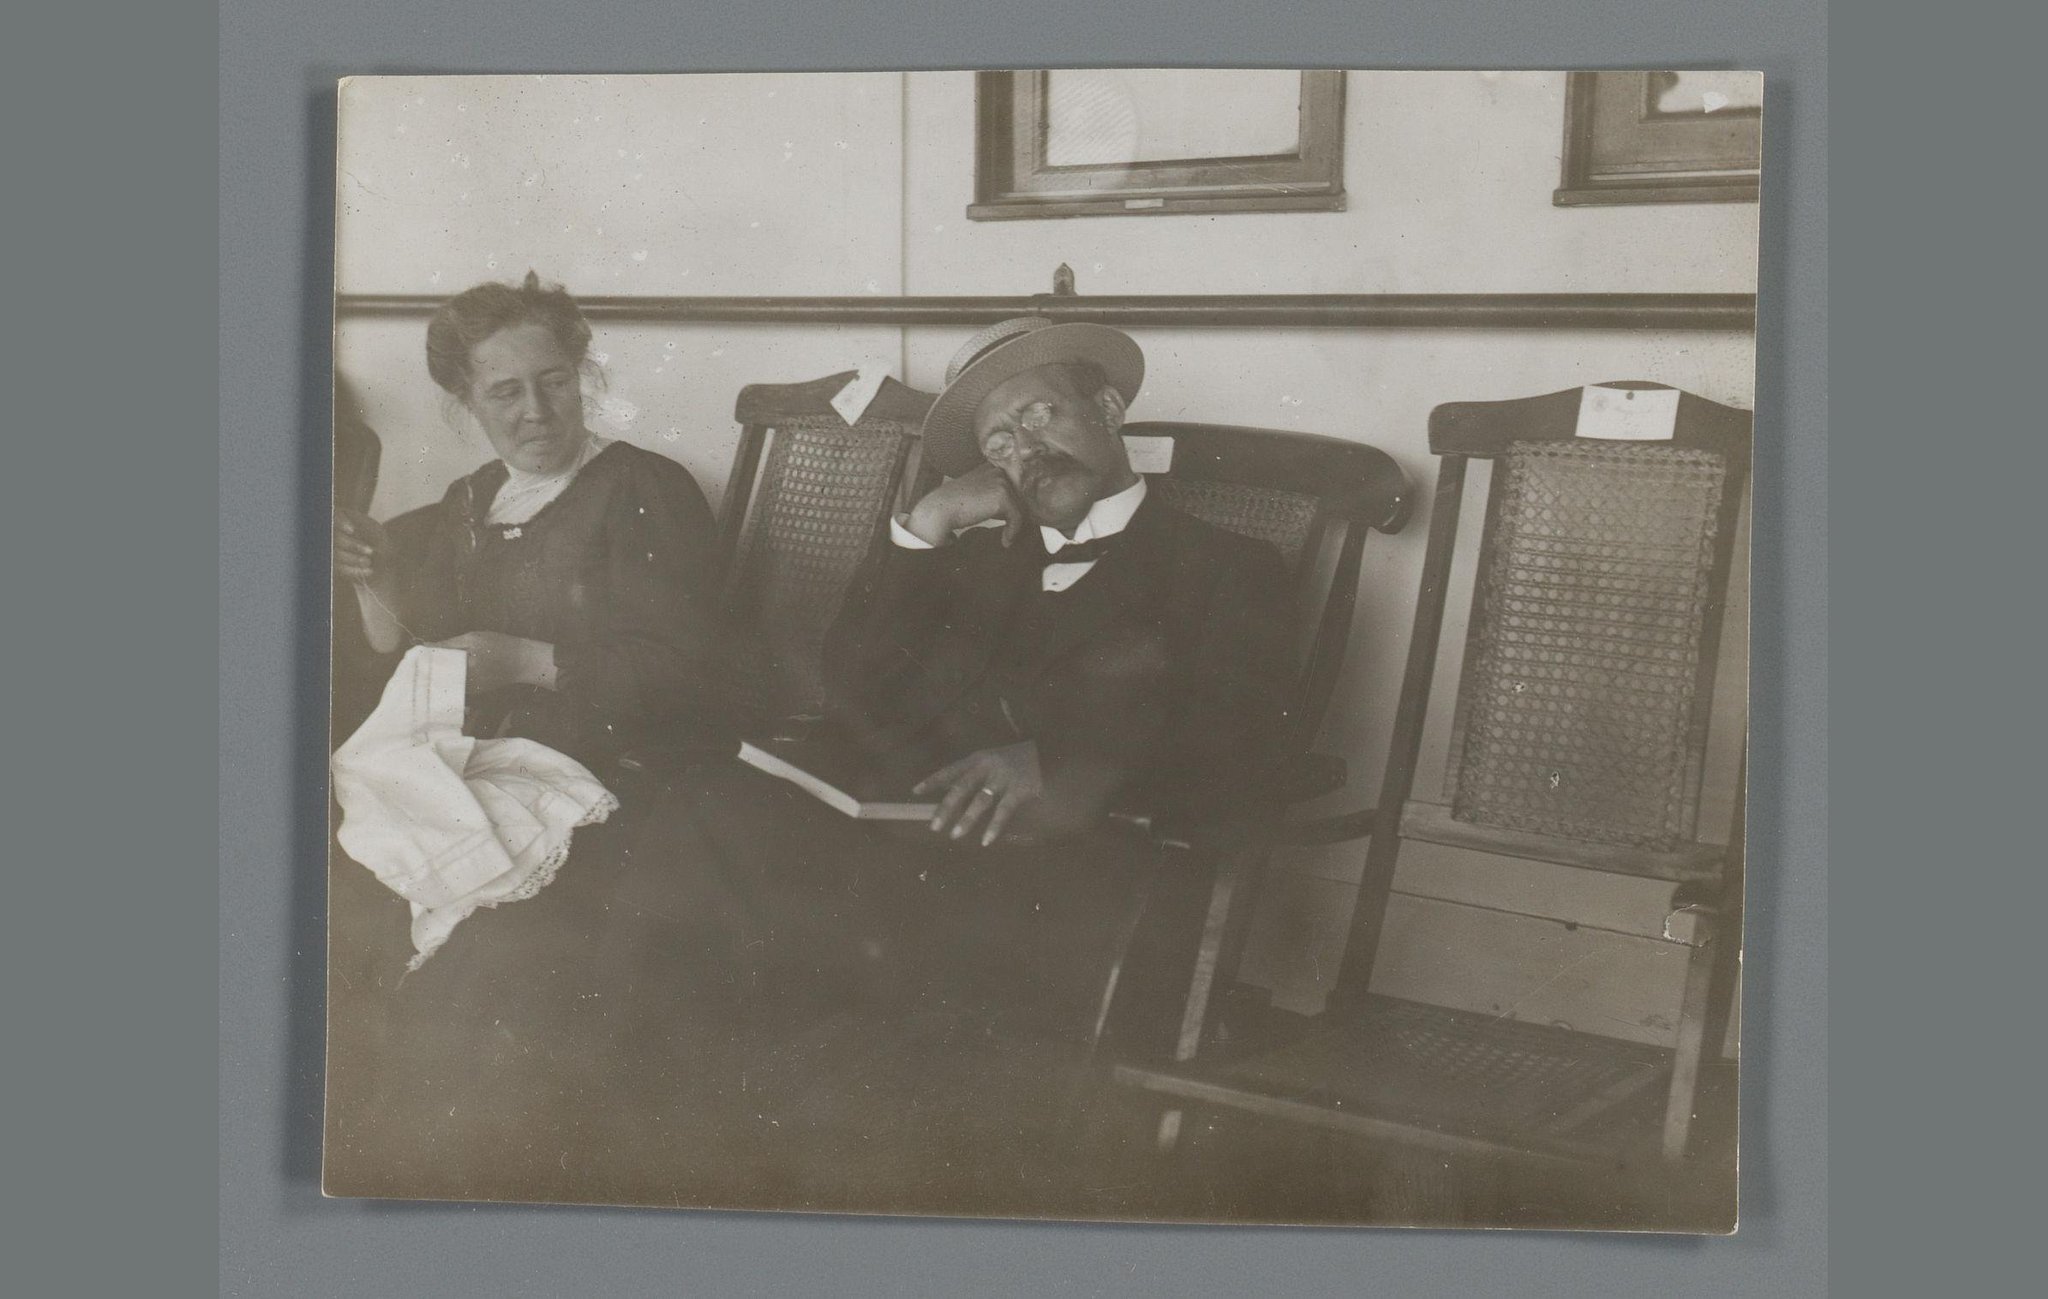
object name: photograph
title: Elisabeth de Jong en een rustende Willem de Jong op het schip Prins der Nederlanden op de terugreis vanuit Zwitserland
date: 1914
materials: paper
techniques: daylight paper print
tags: elisabeth de jong-van tonderen, willem de jong (fotograaf), historical persons, passengers ~ ship, resting, netherlands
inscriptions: inscription: ‘Op de boot van/ Jenna in Holland’